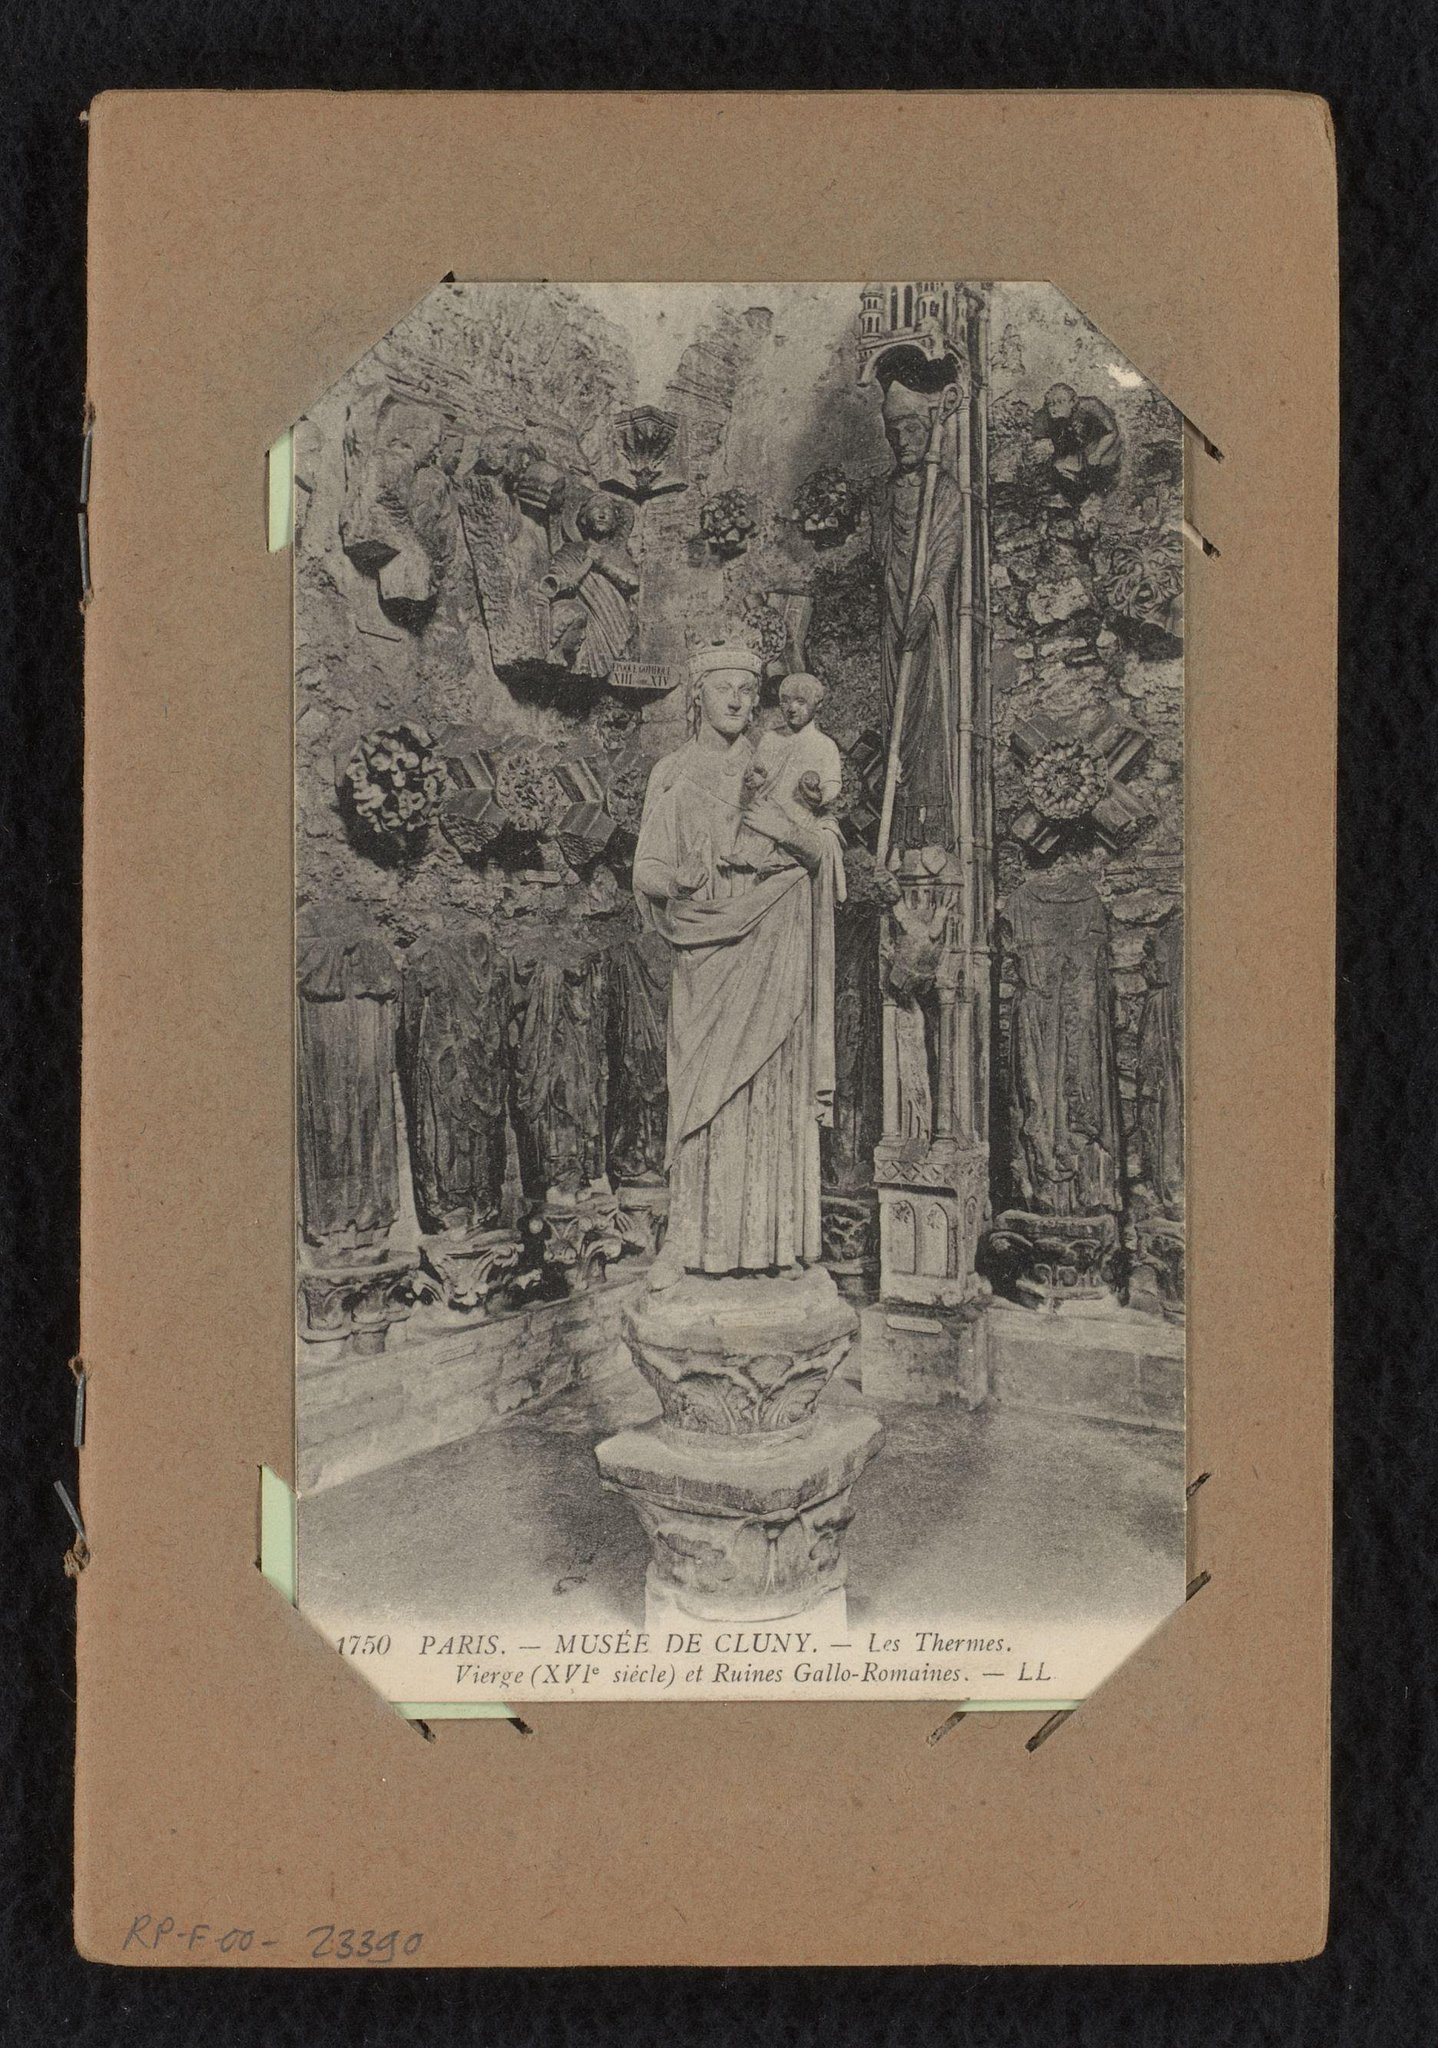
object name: postcard album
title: Album met voorstellingen van het Musée de Cluny en het Panthéon in Parijs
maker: jan petrus ponstijn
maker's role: draughtsman, print maker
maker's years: 1883-1970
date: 1920-1940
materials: paper, cardboard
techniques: photograph, gelatin silver print, rotogravure, stapling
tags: permanent exhibition, museum, picture, painting, interior ~ representation of a building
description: Album met 16 prentbriefkaarten in zwart-wit op 16 pagina's. De voorstellingen zijn van het interieur van het Musée de Cluny in Parijs en van het exterieur en interieur van het Pantheon in Parijs. De prentbriefkaarten zijn verzameld door kunstenaar Jan Petrus Ponstijn.